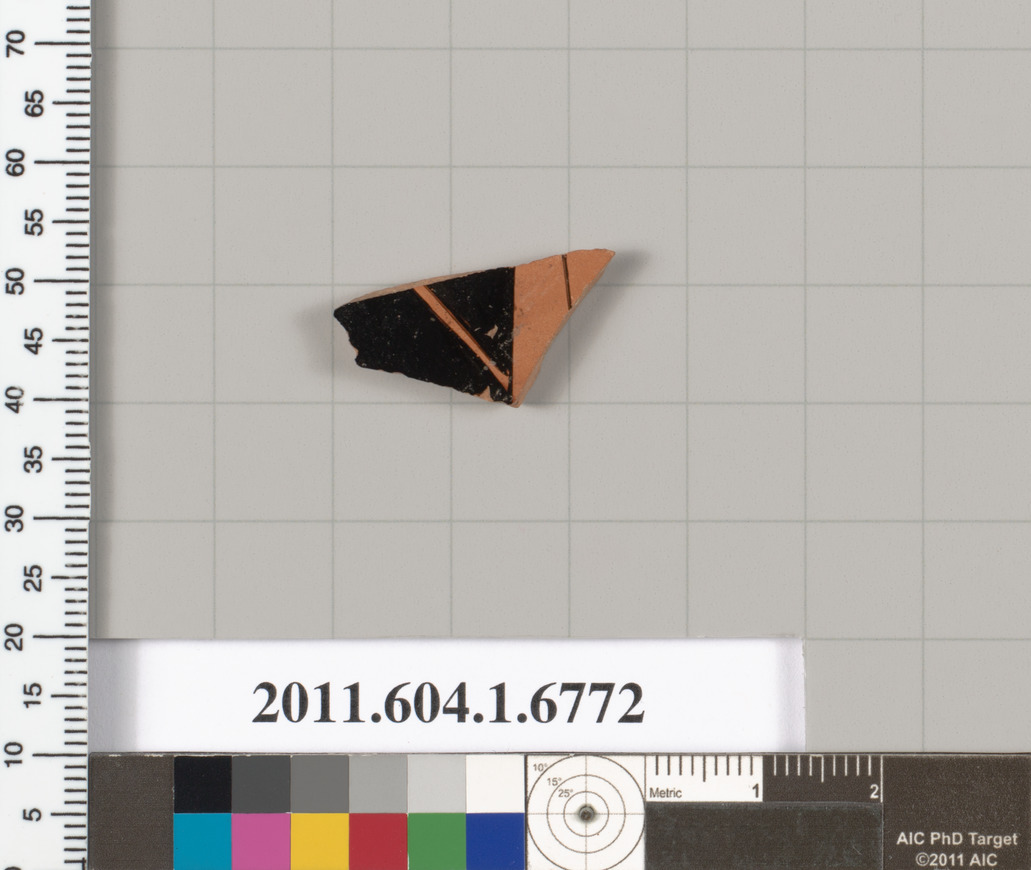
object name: kylix fragment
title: Terracotta fragment of a kylix (drinking cup)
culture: greek, attic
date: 490-470 BCE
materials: terracotta